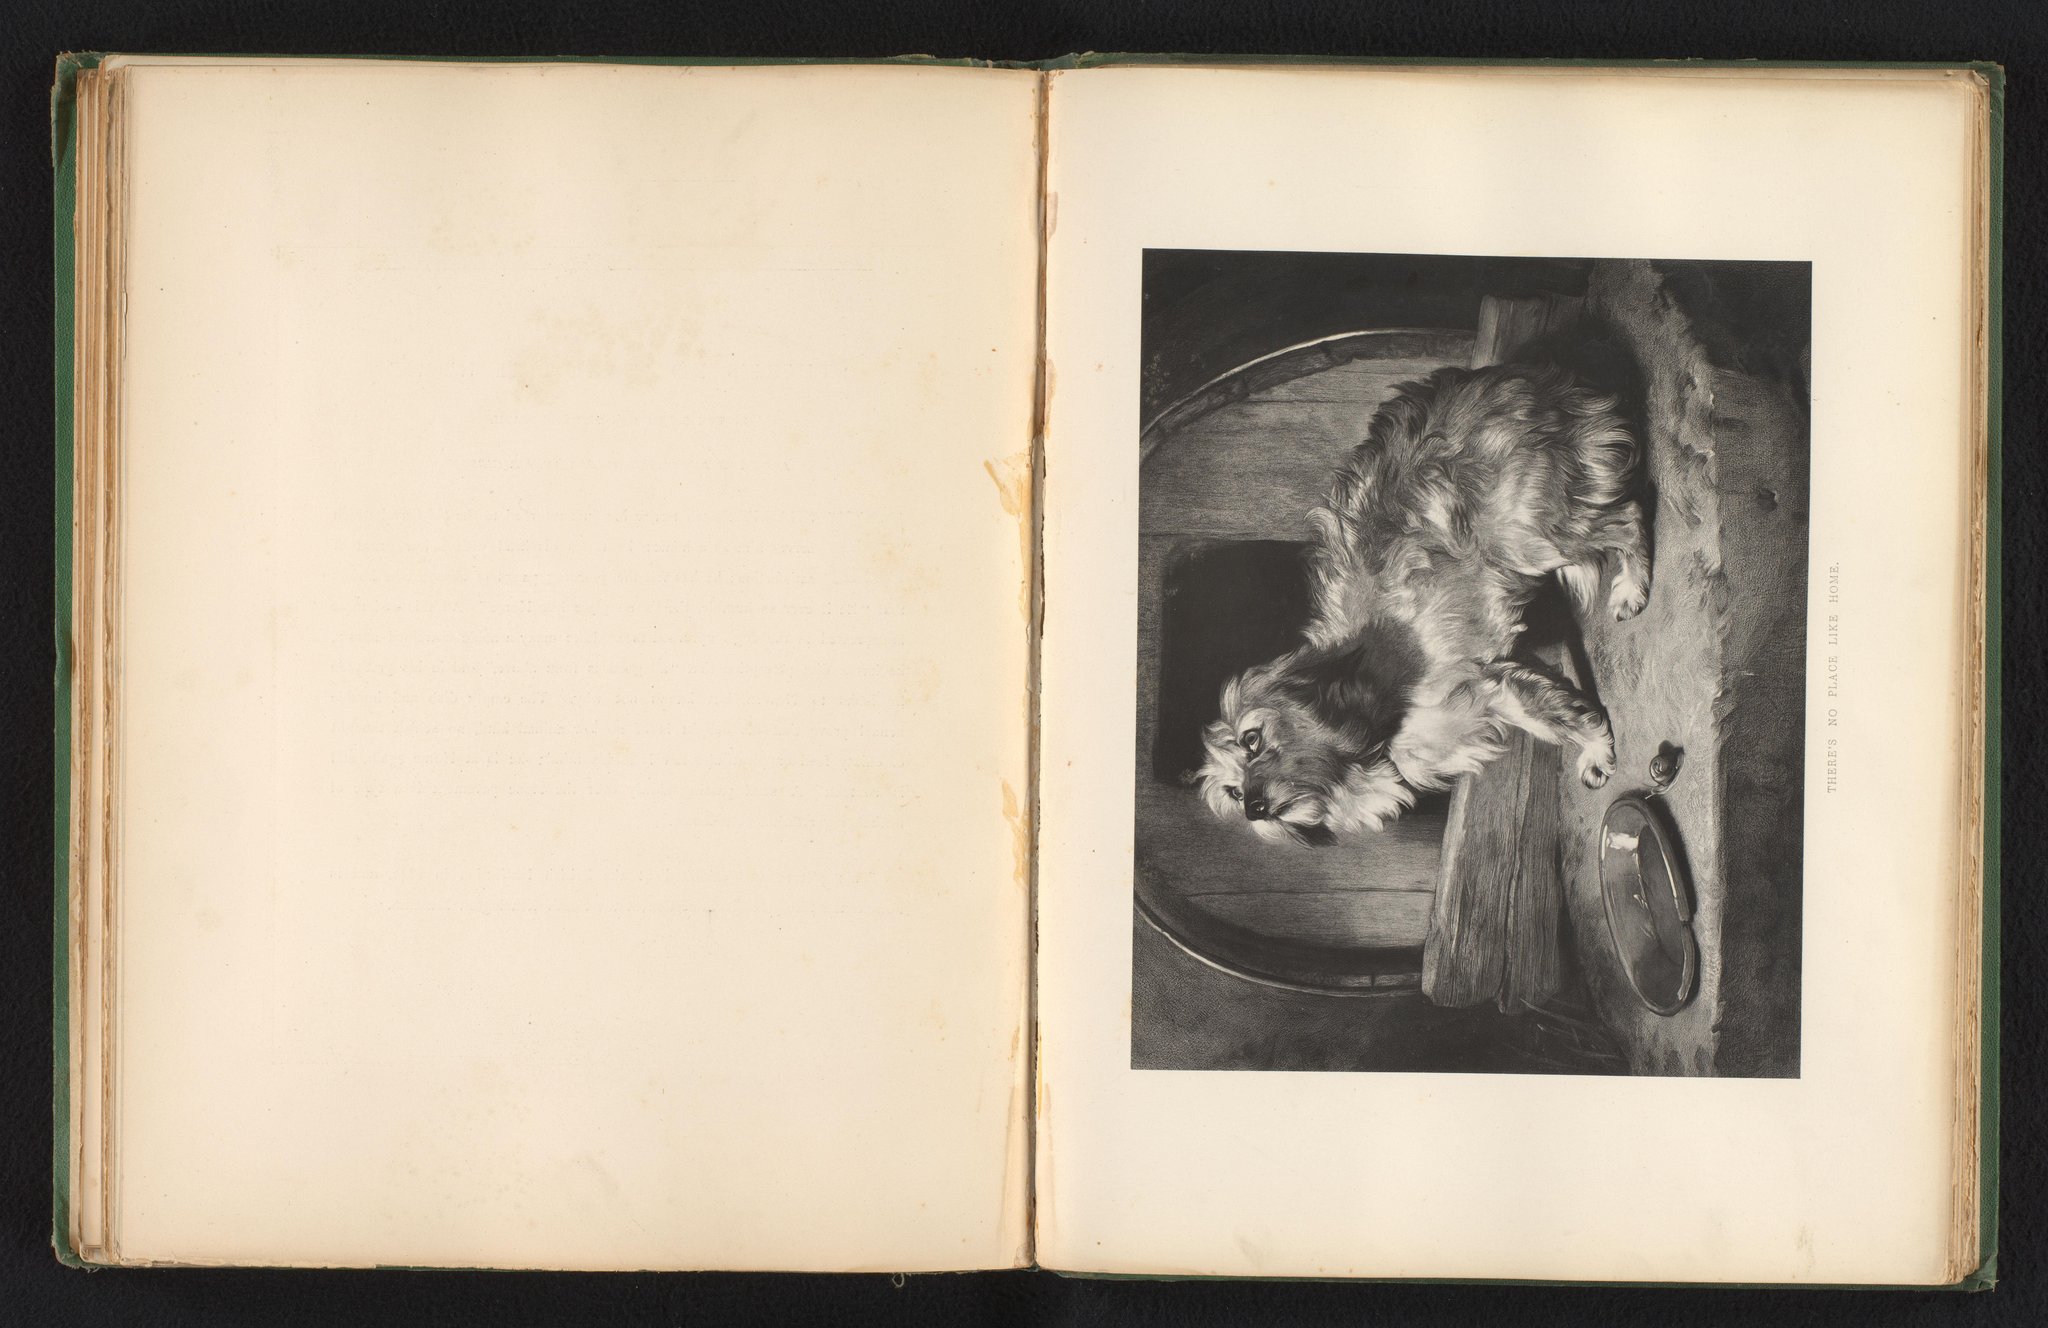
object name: photomechanical print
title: Reproductie van een prent naar een schilderij van een hond door Edwin Landseer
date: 1878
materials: paper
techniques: woodburytype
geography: london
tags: dog